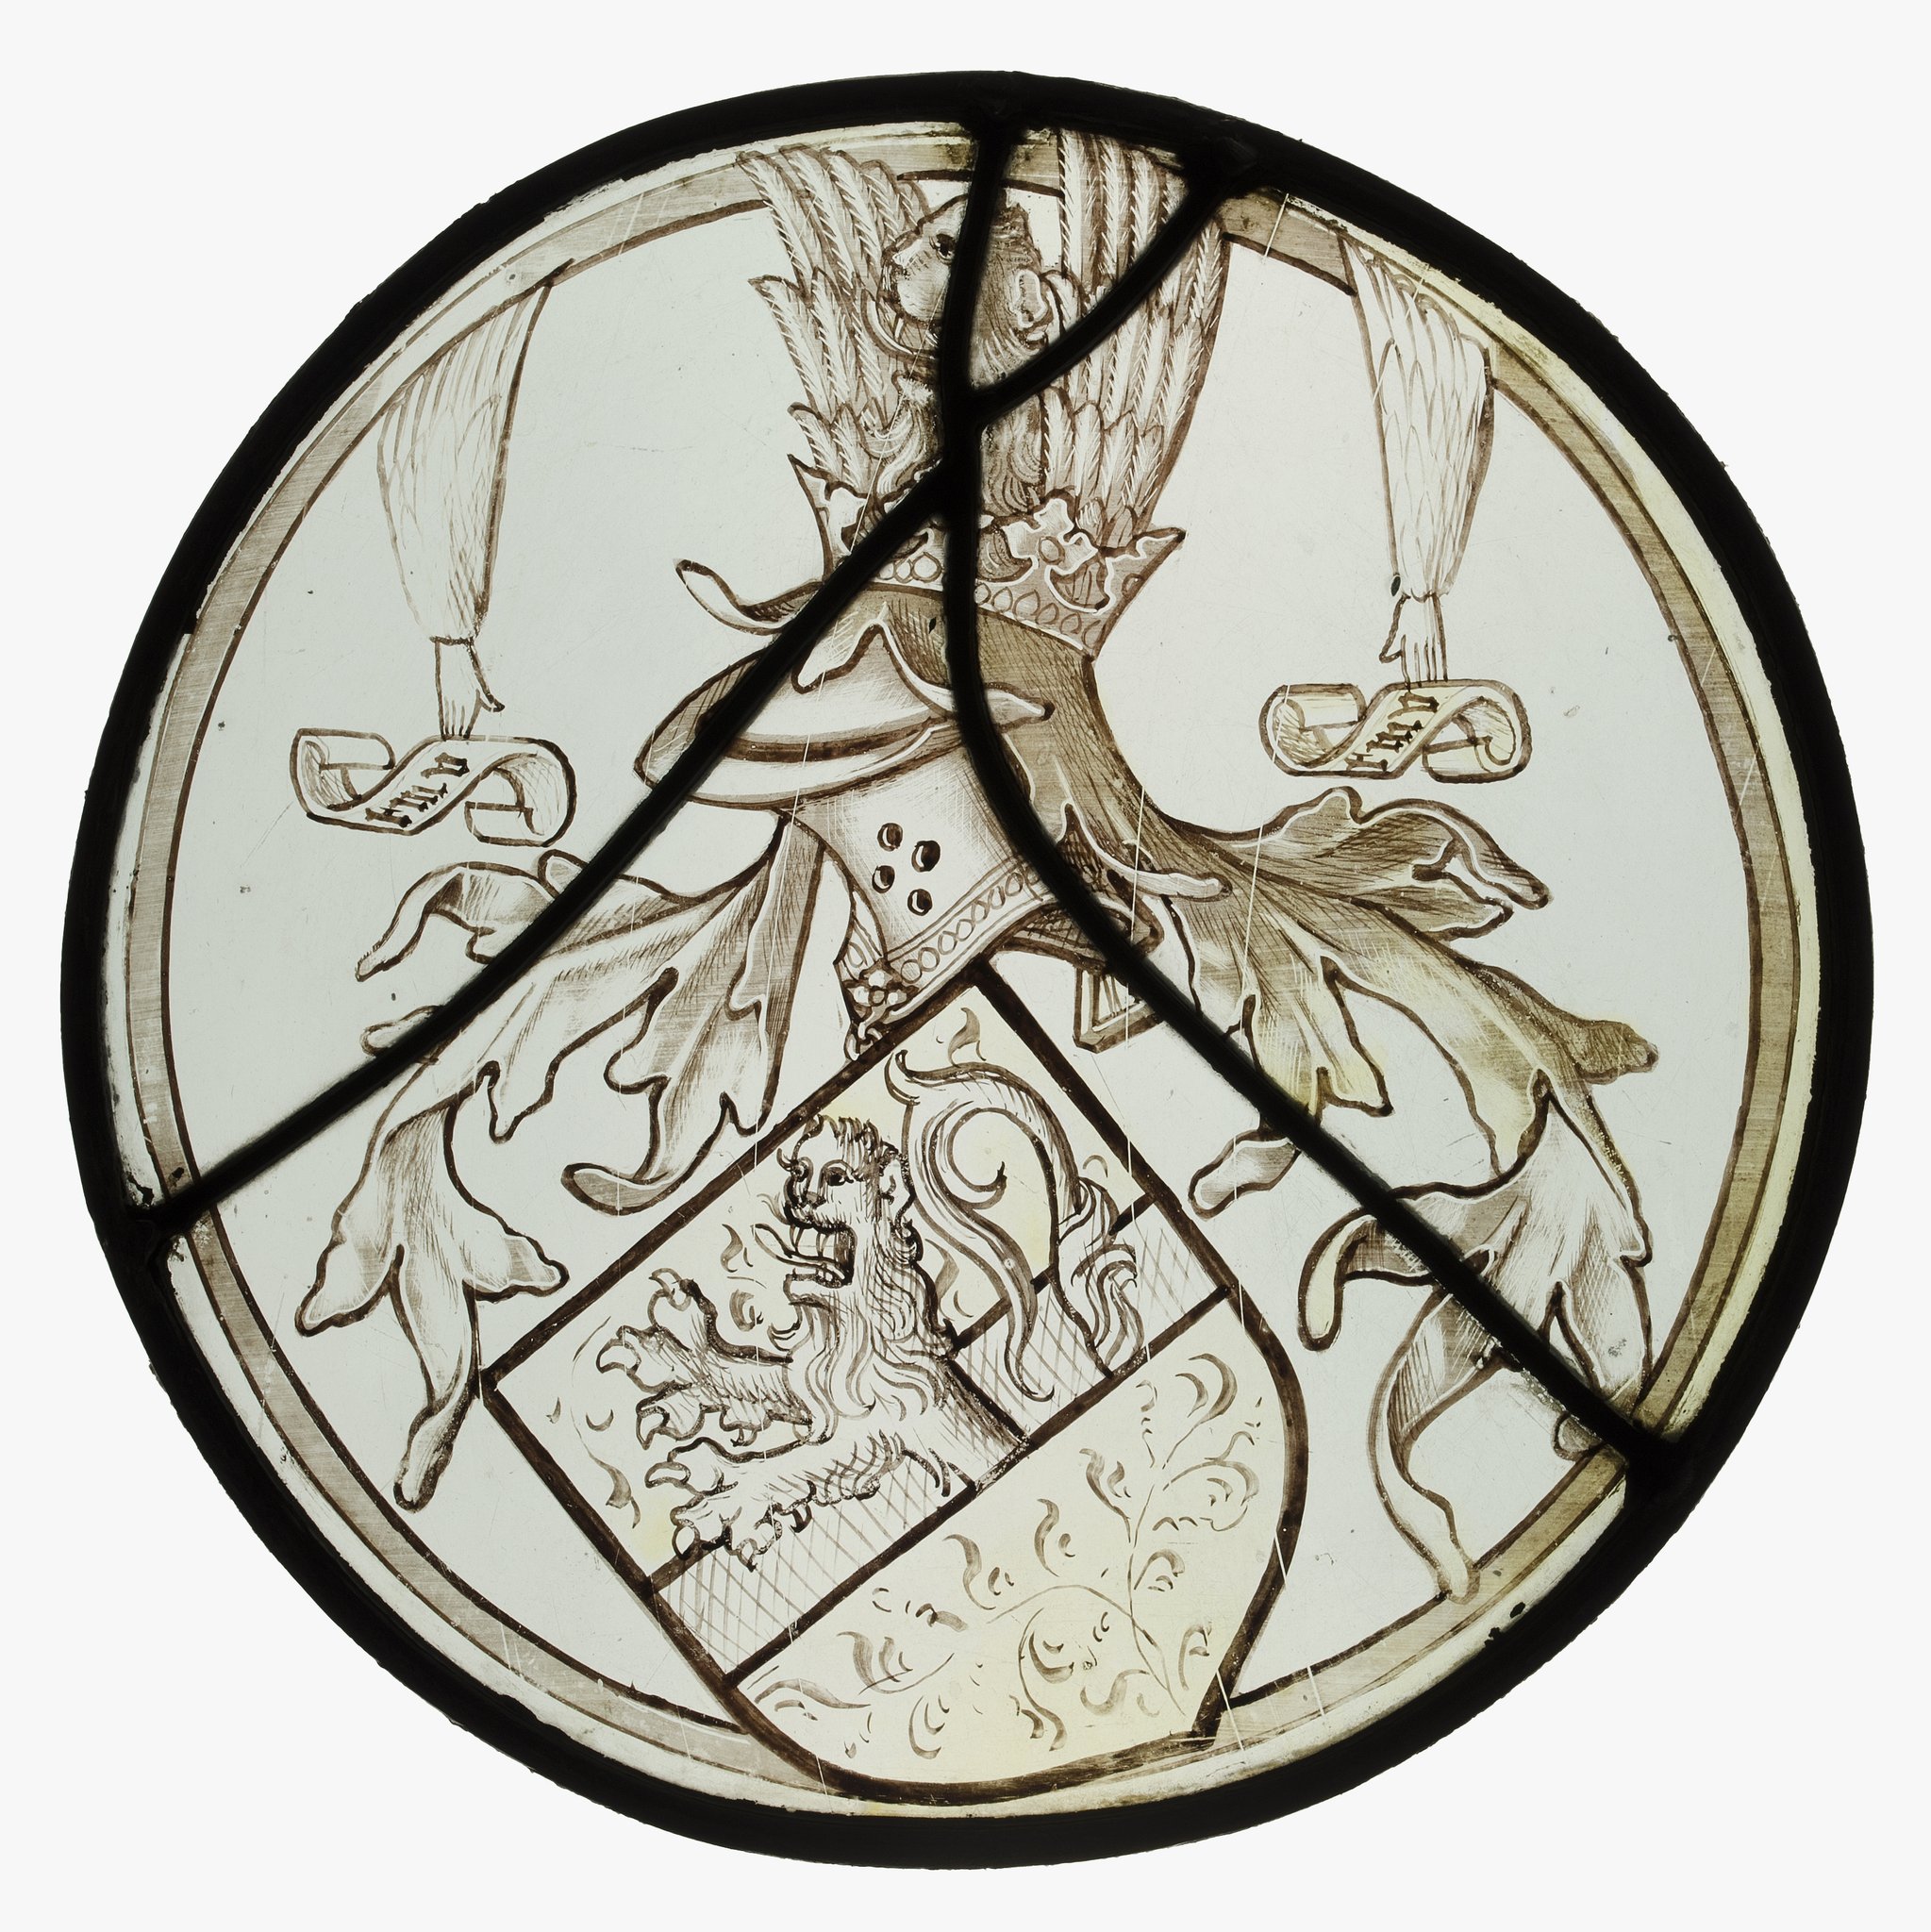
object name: roundel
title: Roundel with Coat of Arms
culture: south netherlandish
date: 1467-1500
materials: glass, paint, pigment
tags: coat of arms